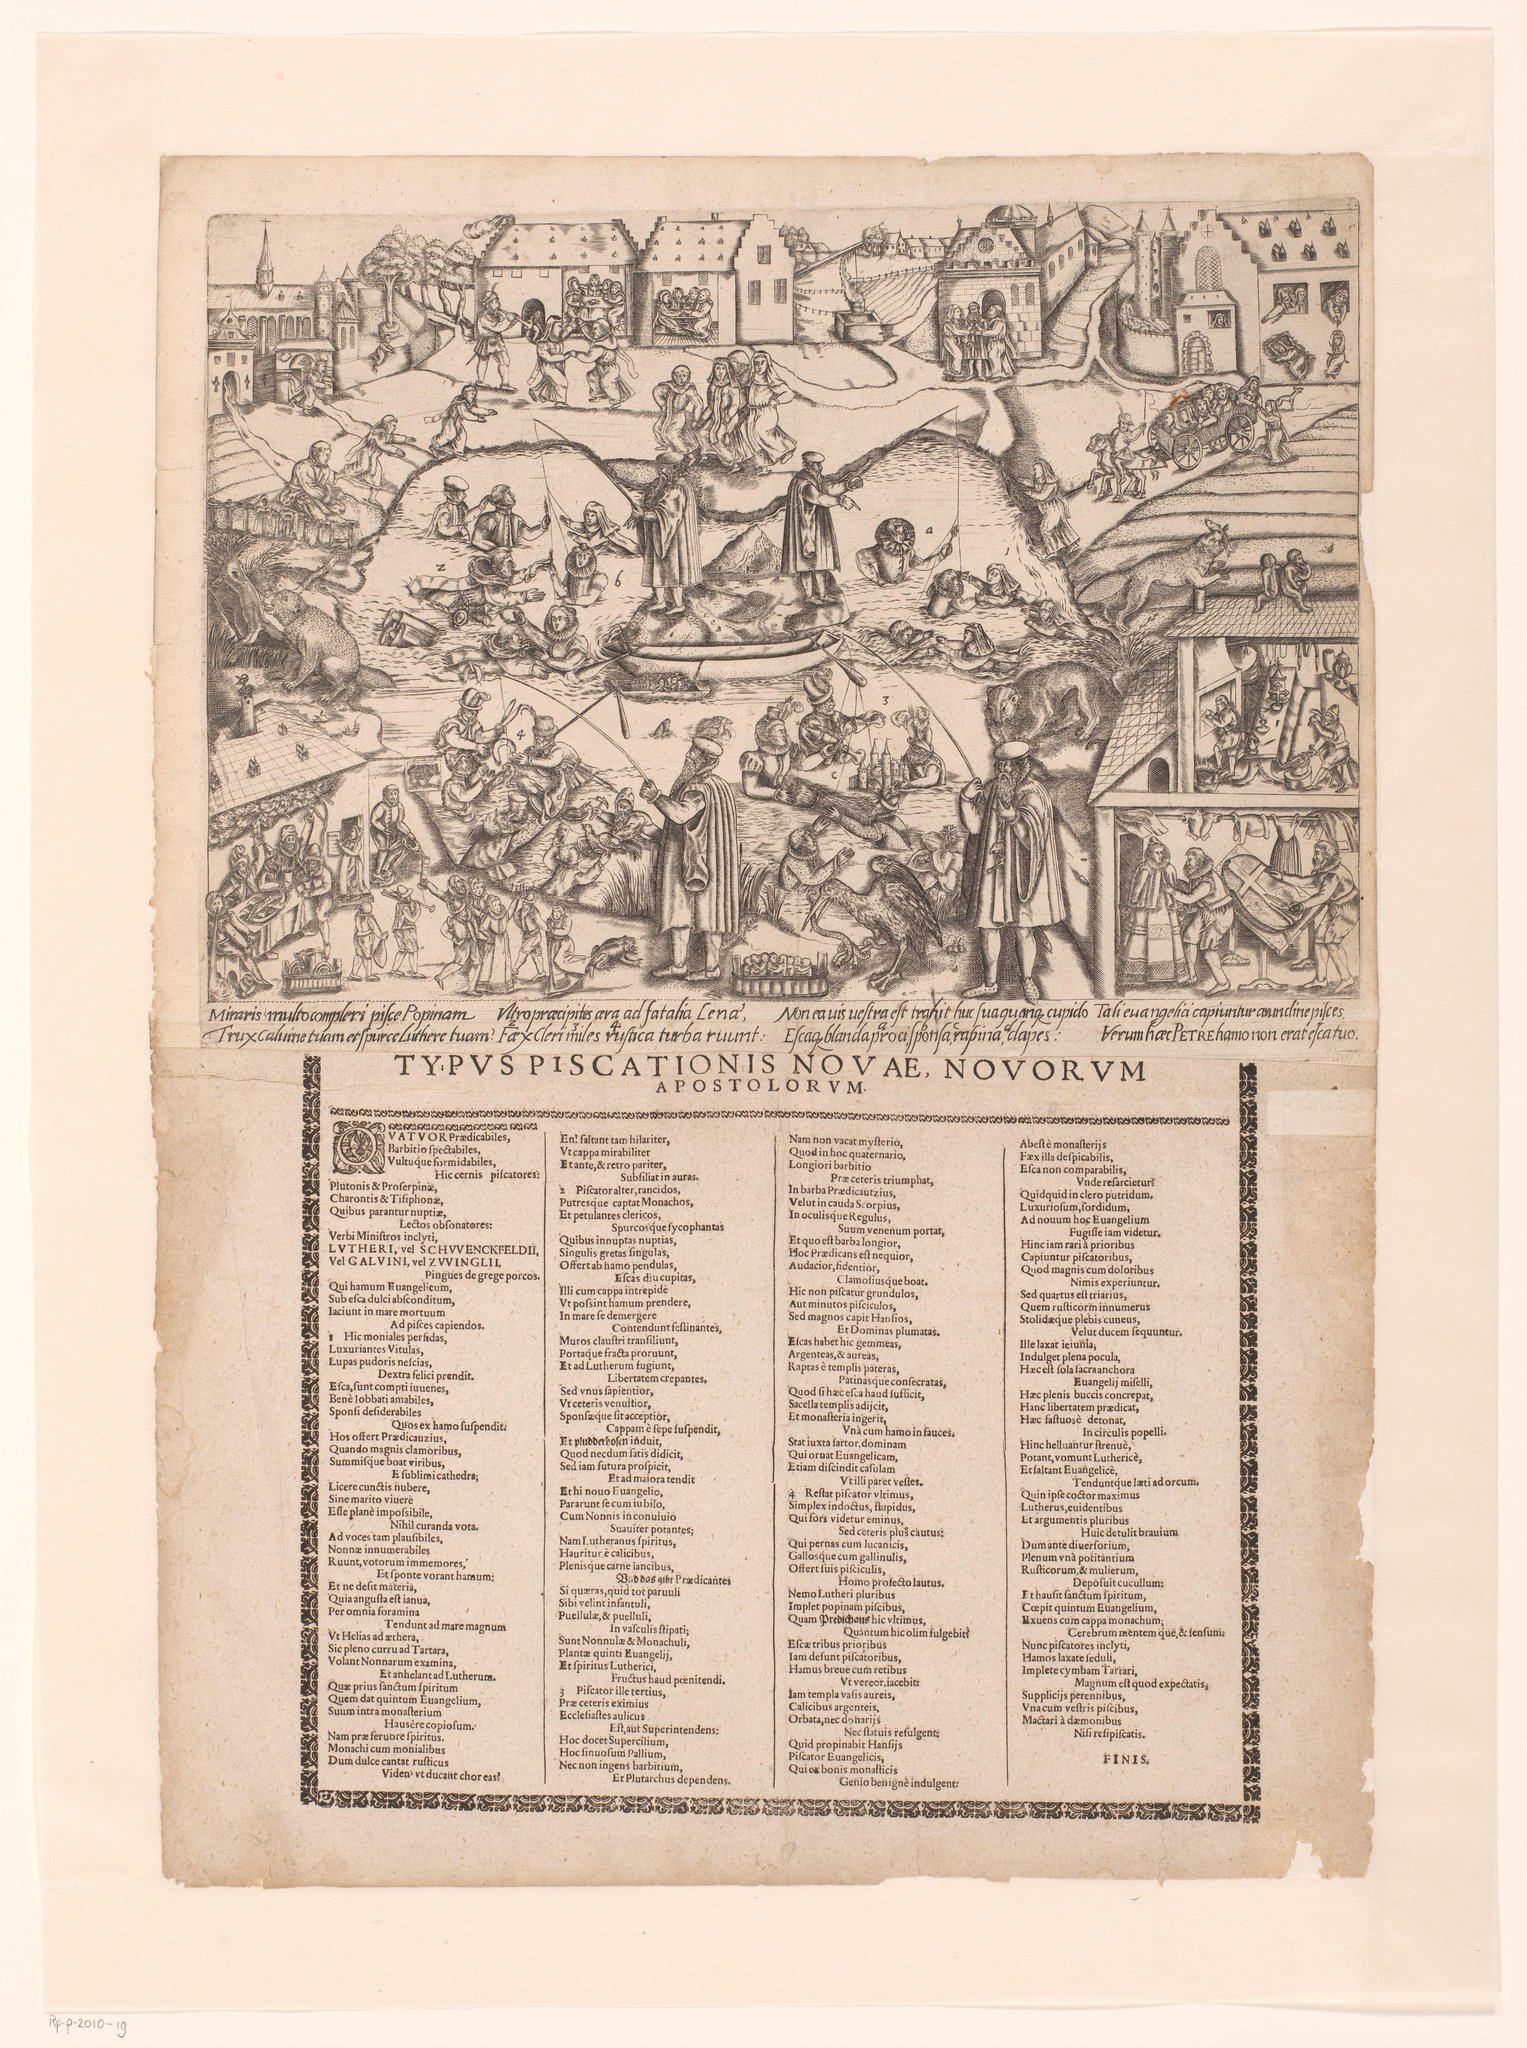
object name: pamphlet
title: Typus piscationis novae novorum apostolorum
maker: Anonymous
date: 1560-1600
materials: paper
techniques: engraving, letterpress printing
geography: germany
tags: clergyman, priest, martin luther, the (true) church vs. other churches and ideas, trying to win souls, fishing for souls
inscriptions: collector's mark: Lugt 2228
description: Allegorische voorstelling waarin Luther, Schwenckfeld, Calvijn en Zwingli zijn voorgesteld vissend in een vijver waarin verschillen typen mensen zwemmen: rijk geklede jonge mannen en vrouwen, monniken, landheren, boeren en ambachtslieden. Daarom heen zijn diverse scènes weergeven in en rond herbergen waarin ondermeer drinkende gezelschappen en dansende monniken figureren. Rechtsonder wordt in een kleermakerswerkplaats een kazuifel verknipt tot vrouwenkleding. Daarboven wordt in een smederij een monstrans omgesmeed. In de voorstelling figureren verschillende dieren: een ooievaar, kikkers, apen, etc. De hoofdrol lijkt weggelegd voor de bever, die drie maal is voorgesteld. Met apart gedrukte Latijnse tekst in boekdruk.